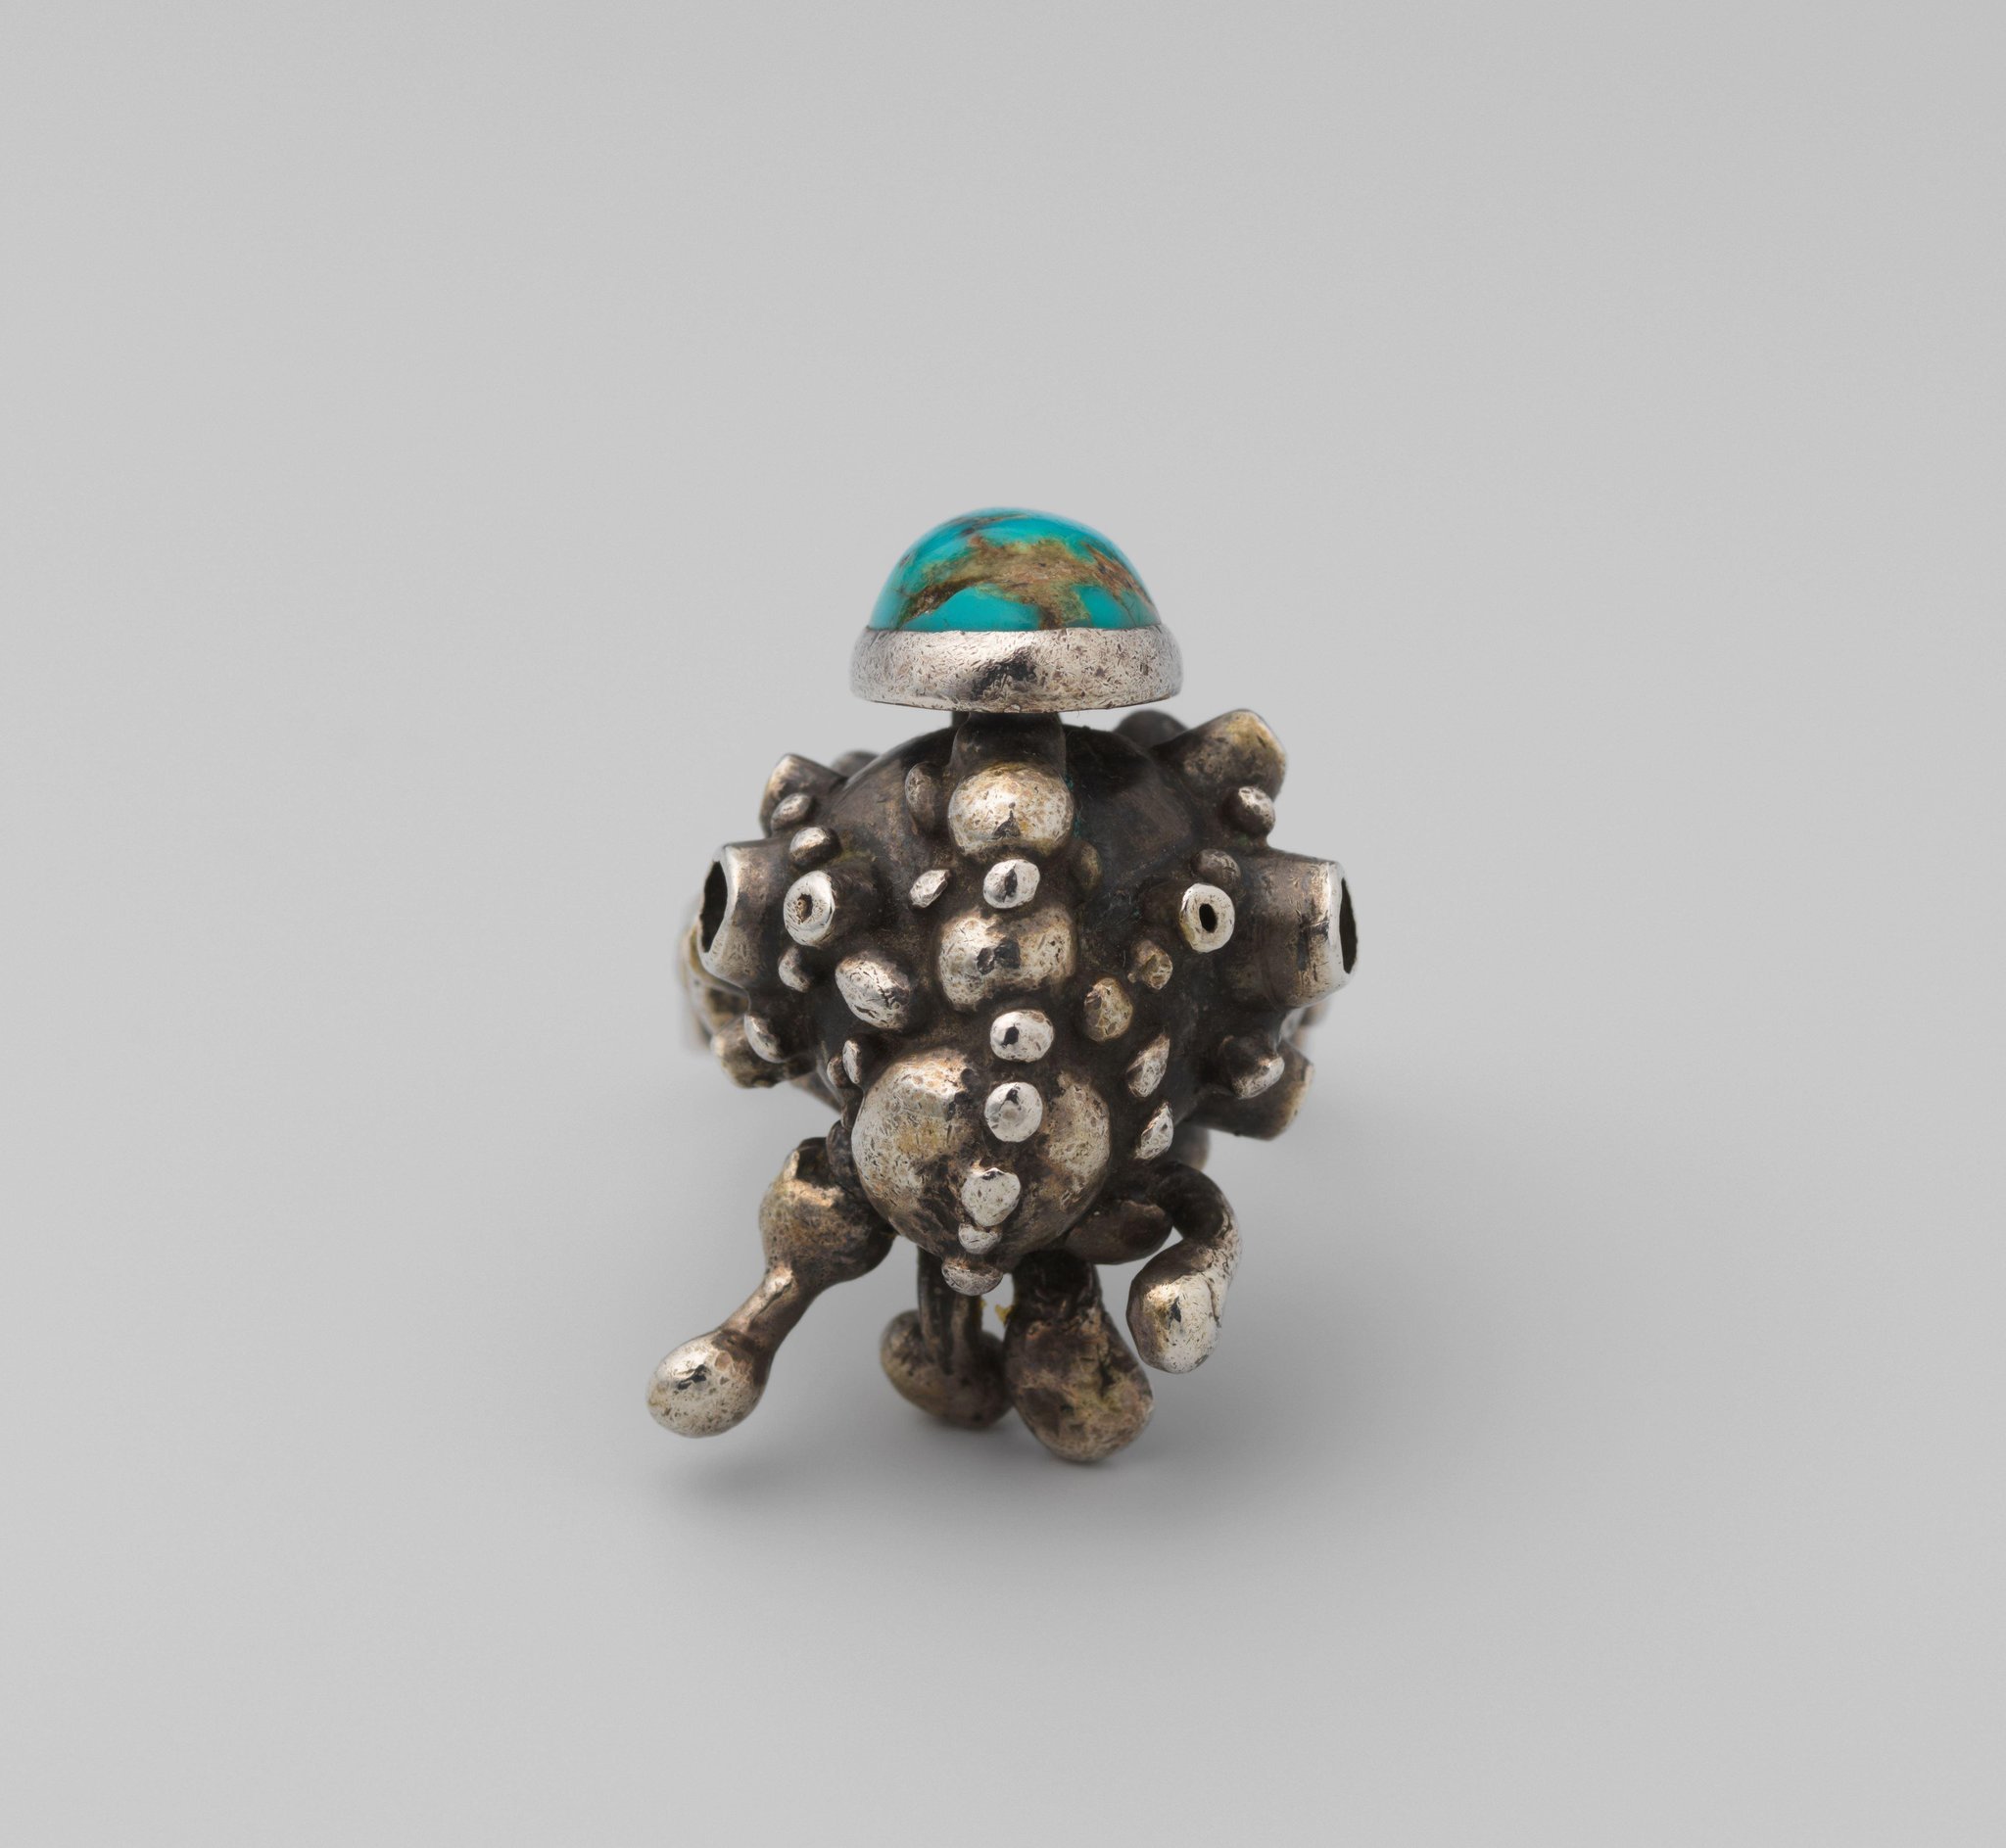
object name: ring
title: Ring 'Draak' van zilver met turkoois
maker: Anonymous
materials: silver, gemstone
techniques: grinding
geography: netherlands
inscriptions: alloy mark, maker's mark: ‘b ?’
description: Ring 'Draak' van zilver met ovaal cabochon geslepen turkoois met moedergesteente.